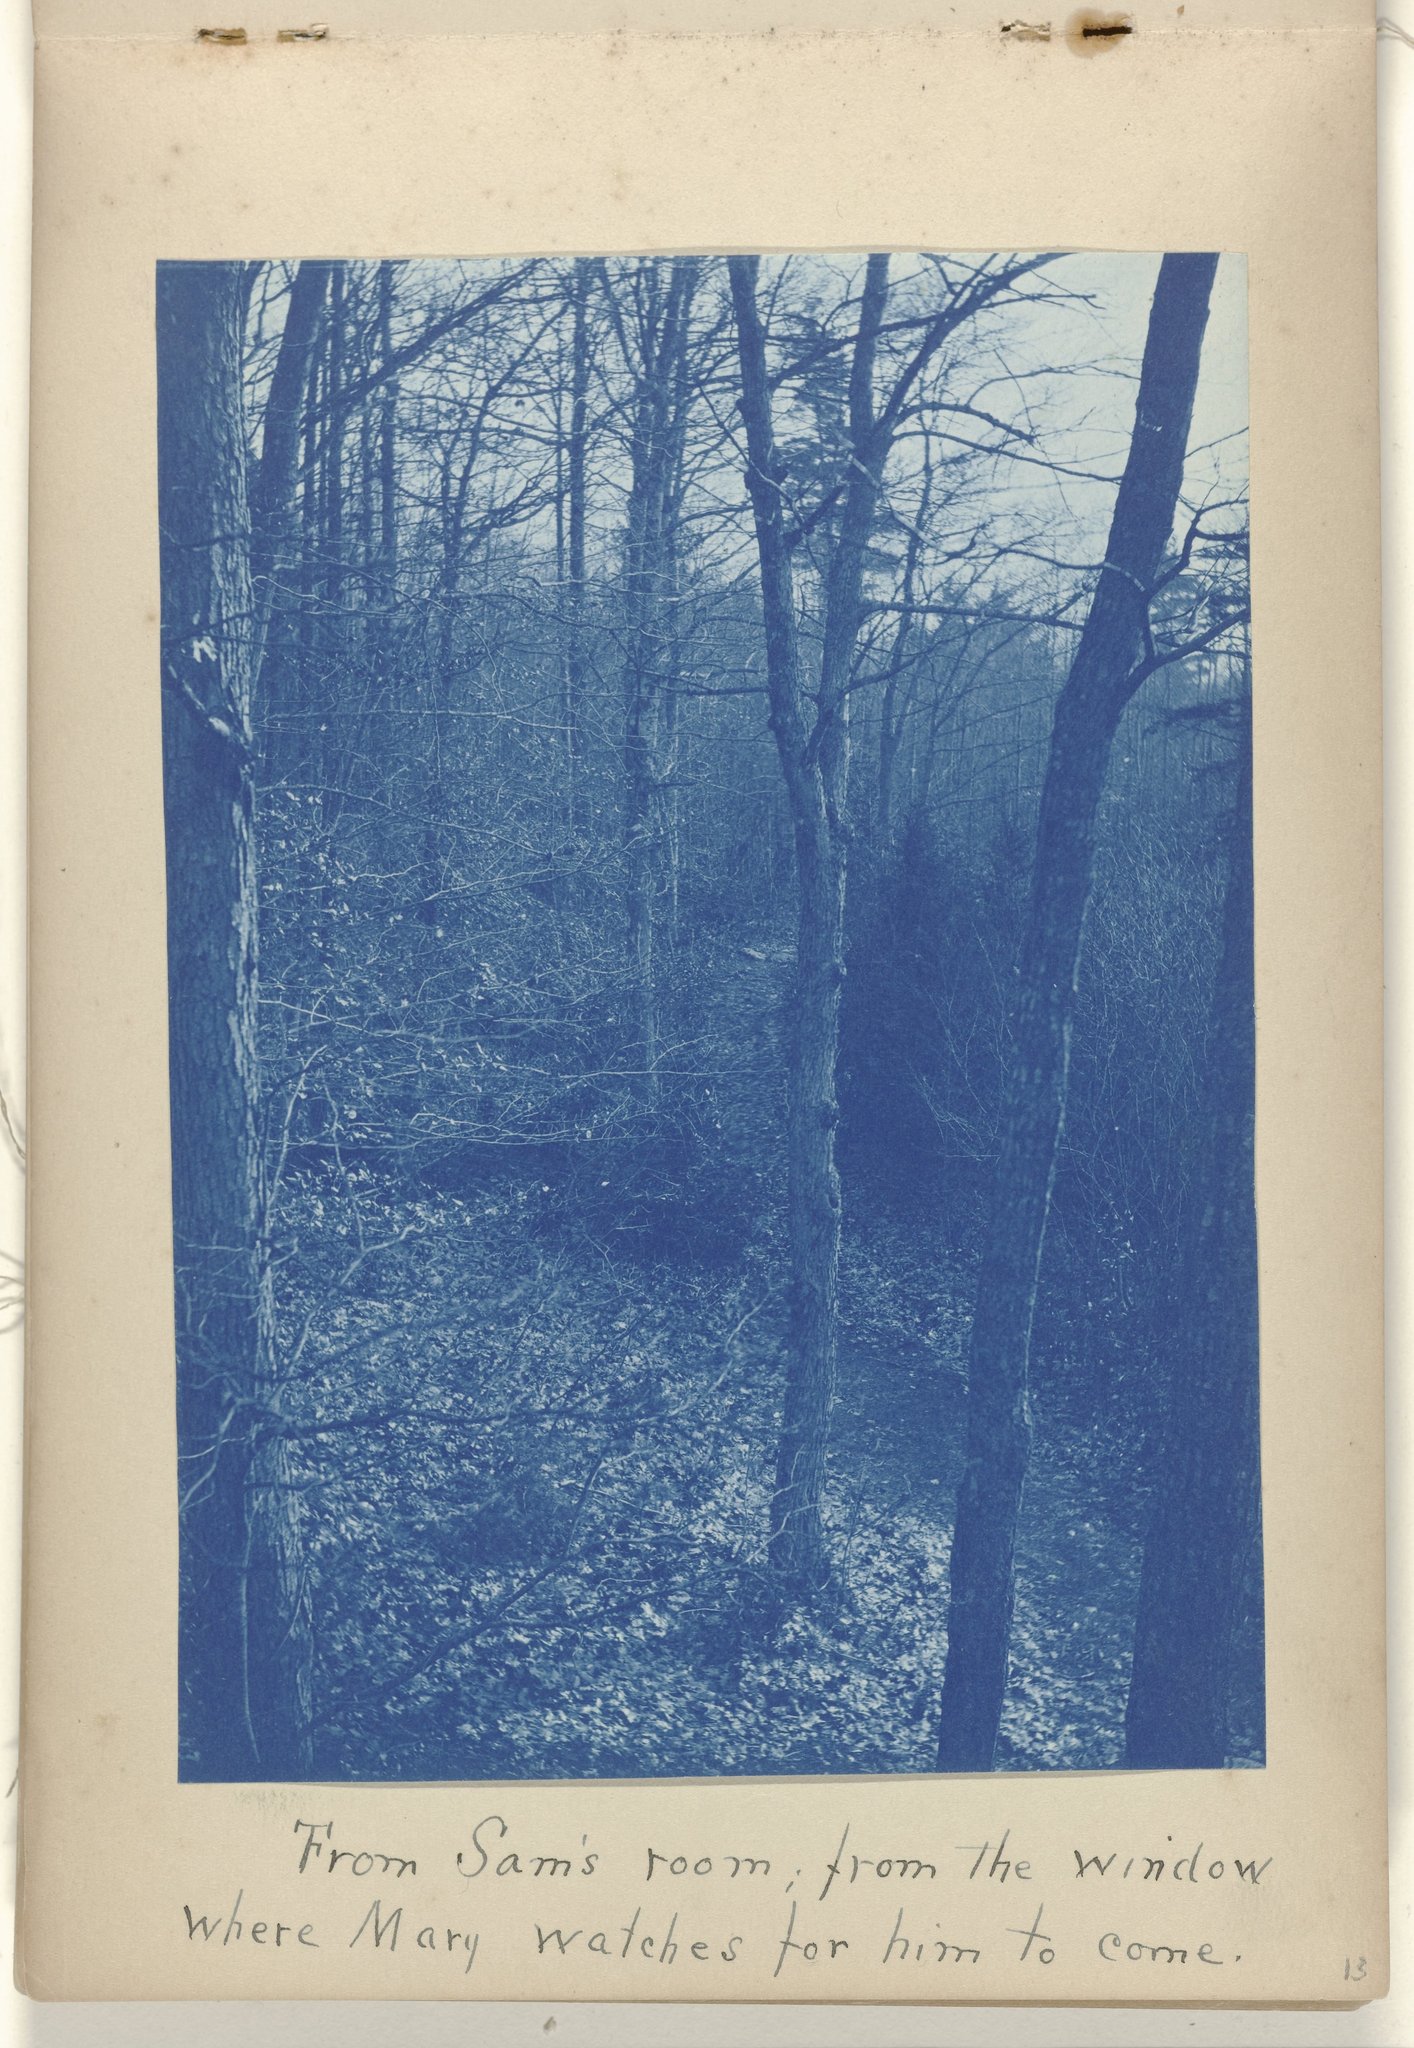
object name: photograph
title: Uitzicht op een bos vanuit een vakantiewoning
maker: Anonymous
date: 1900-1910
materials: paper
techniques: cyanotype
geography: united states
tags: forest, wood, united states of america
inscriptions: annotation: ‘From Sam's room; from the window/ where Mary watches for him to come’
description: Uitzicht op een bos vanuit een vakantiewoning. Onderdeel van een fotoalbum met vijftien cyanotypieën, gemaakt in Camp Avery in de Verenigde Staten.